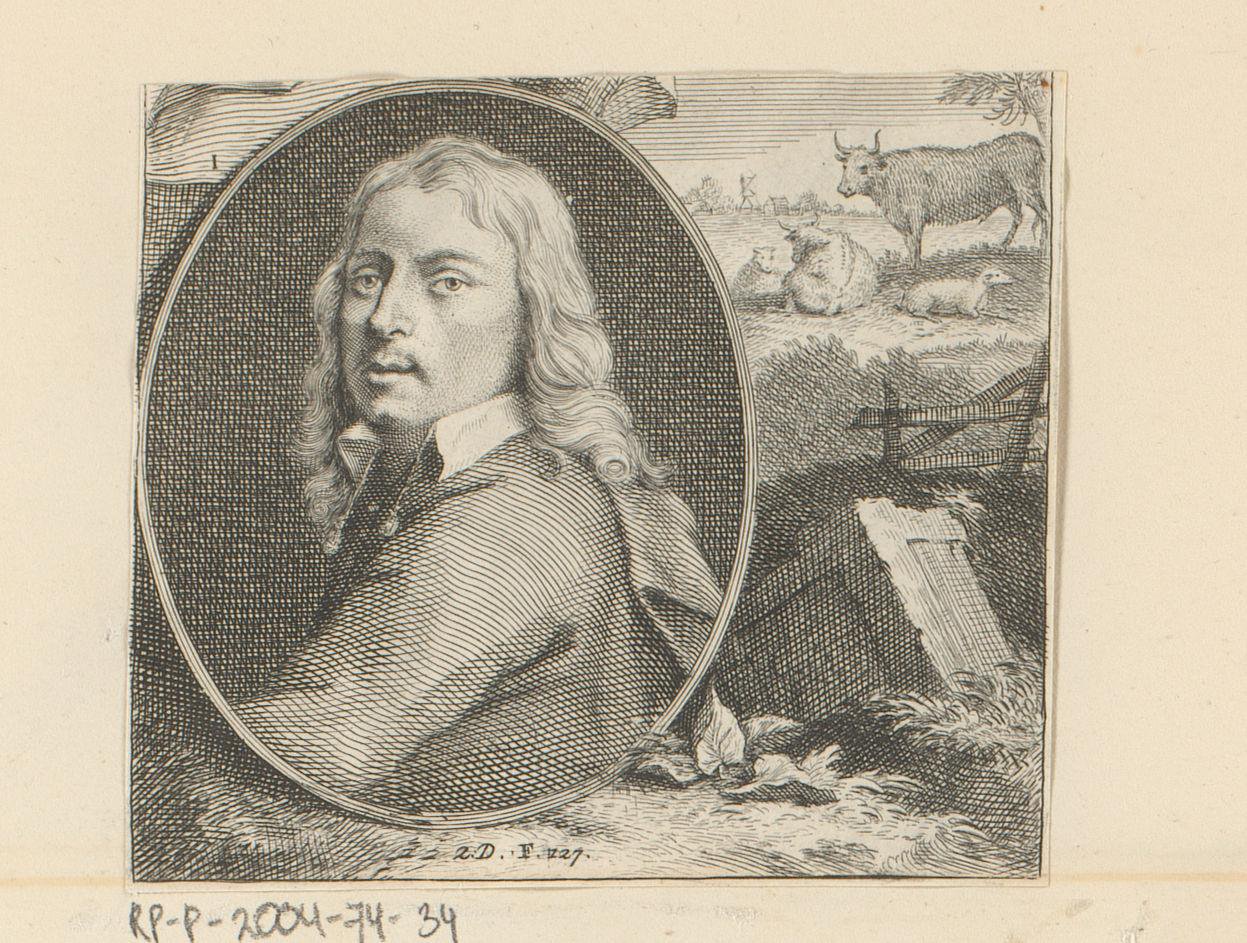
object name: album leaf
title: Portret van Paulus Potter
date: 1718-1721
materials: paper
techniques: engraving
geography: amsterdam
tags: paulus potter, historical persons, portrait, self-portrait of painter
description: Prent uit: Houbraken, Arnold. De groote schouburgh der Nederlantsche konstschilders en schilderessen (...). 3 dln. Amsterdam: Antonina Houbraken, 1721, dl. 2, p. 126. Op de volledige prent staat een portret van Jacob van der Does, maar is hier afgesneden. De samensteller heeft deze prent in het album geplakt als illustratie bij: Pilkington, Matthew en Johann Heinrich Füssli. A dictionary of painters, from the revival of the art to the present period. 4 dln. Londen: John Crowder, 1805, dl. 3, p. 413.